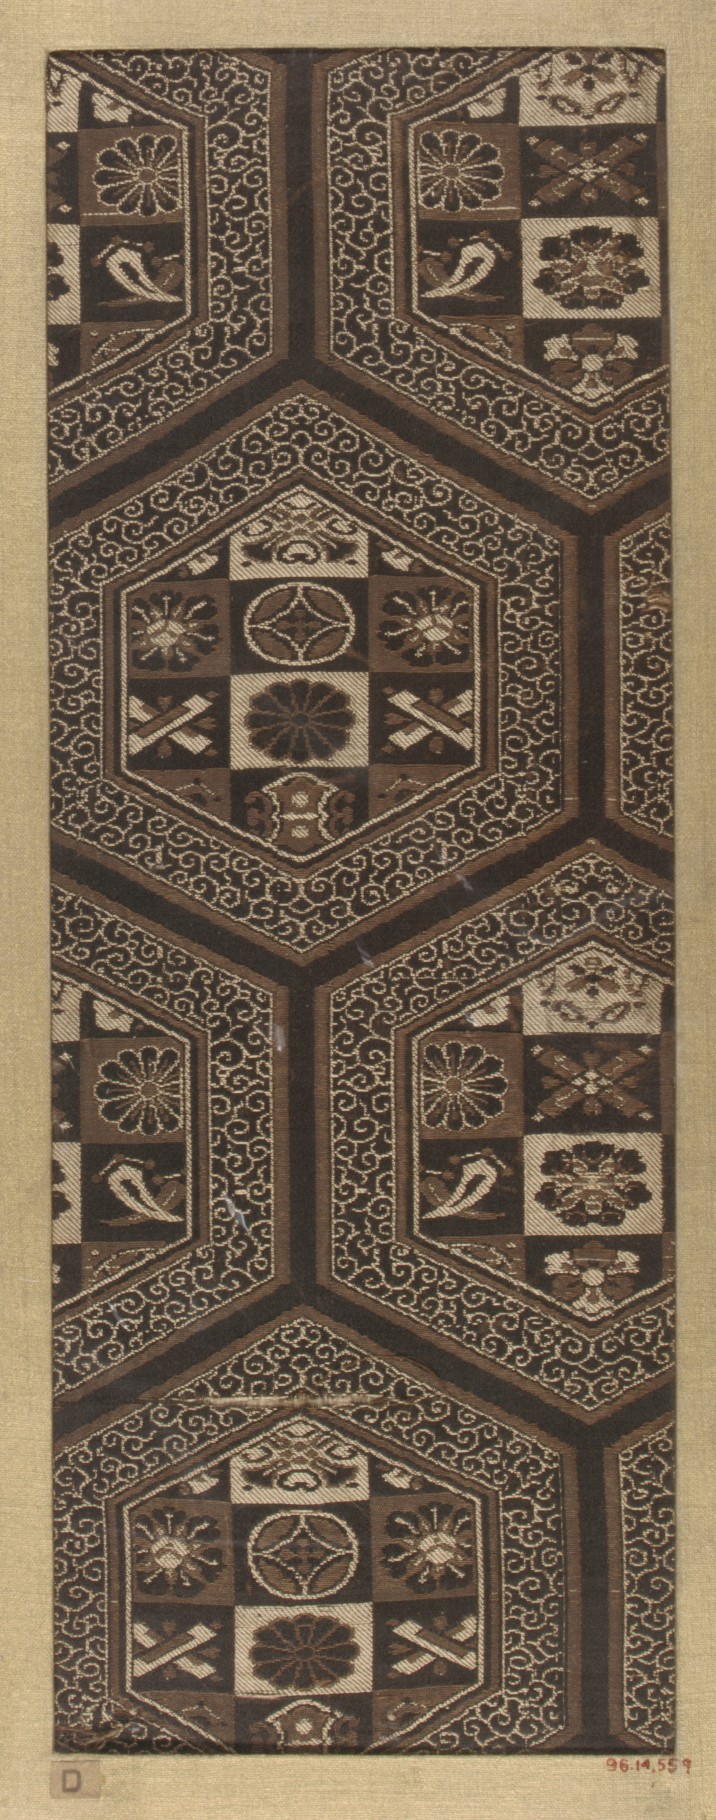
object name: piece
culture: japanese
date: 1701-1900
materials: silk